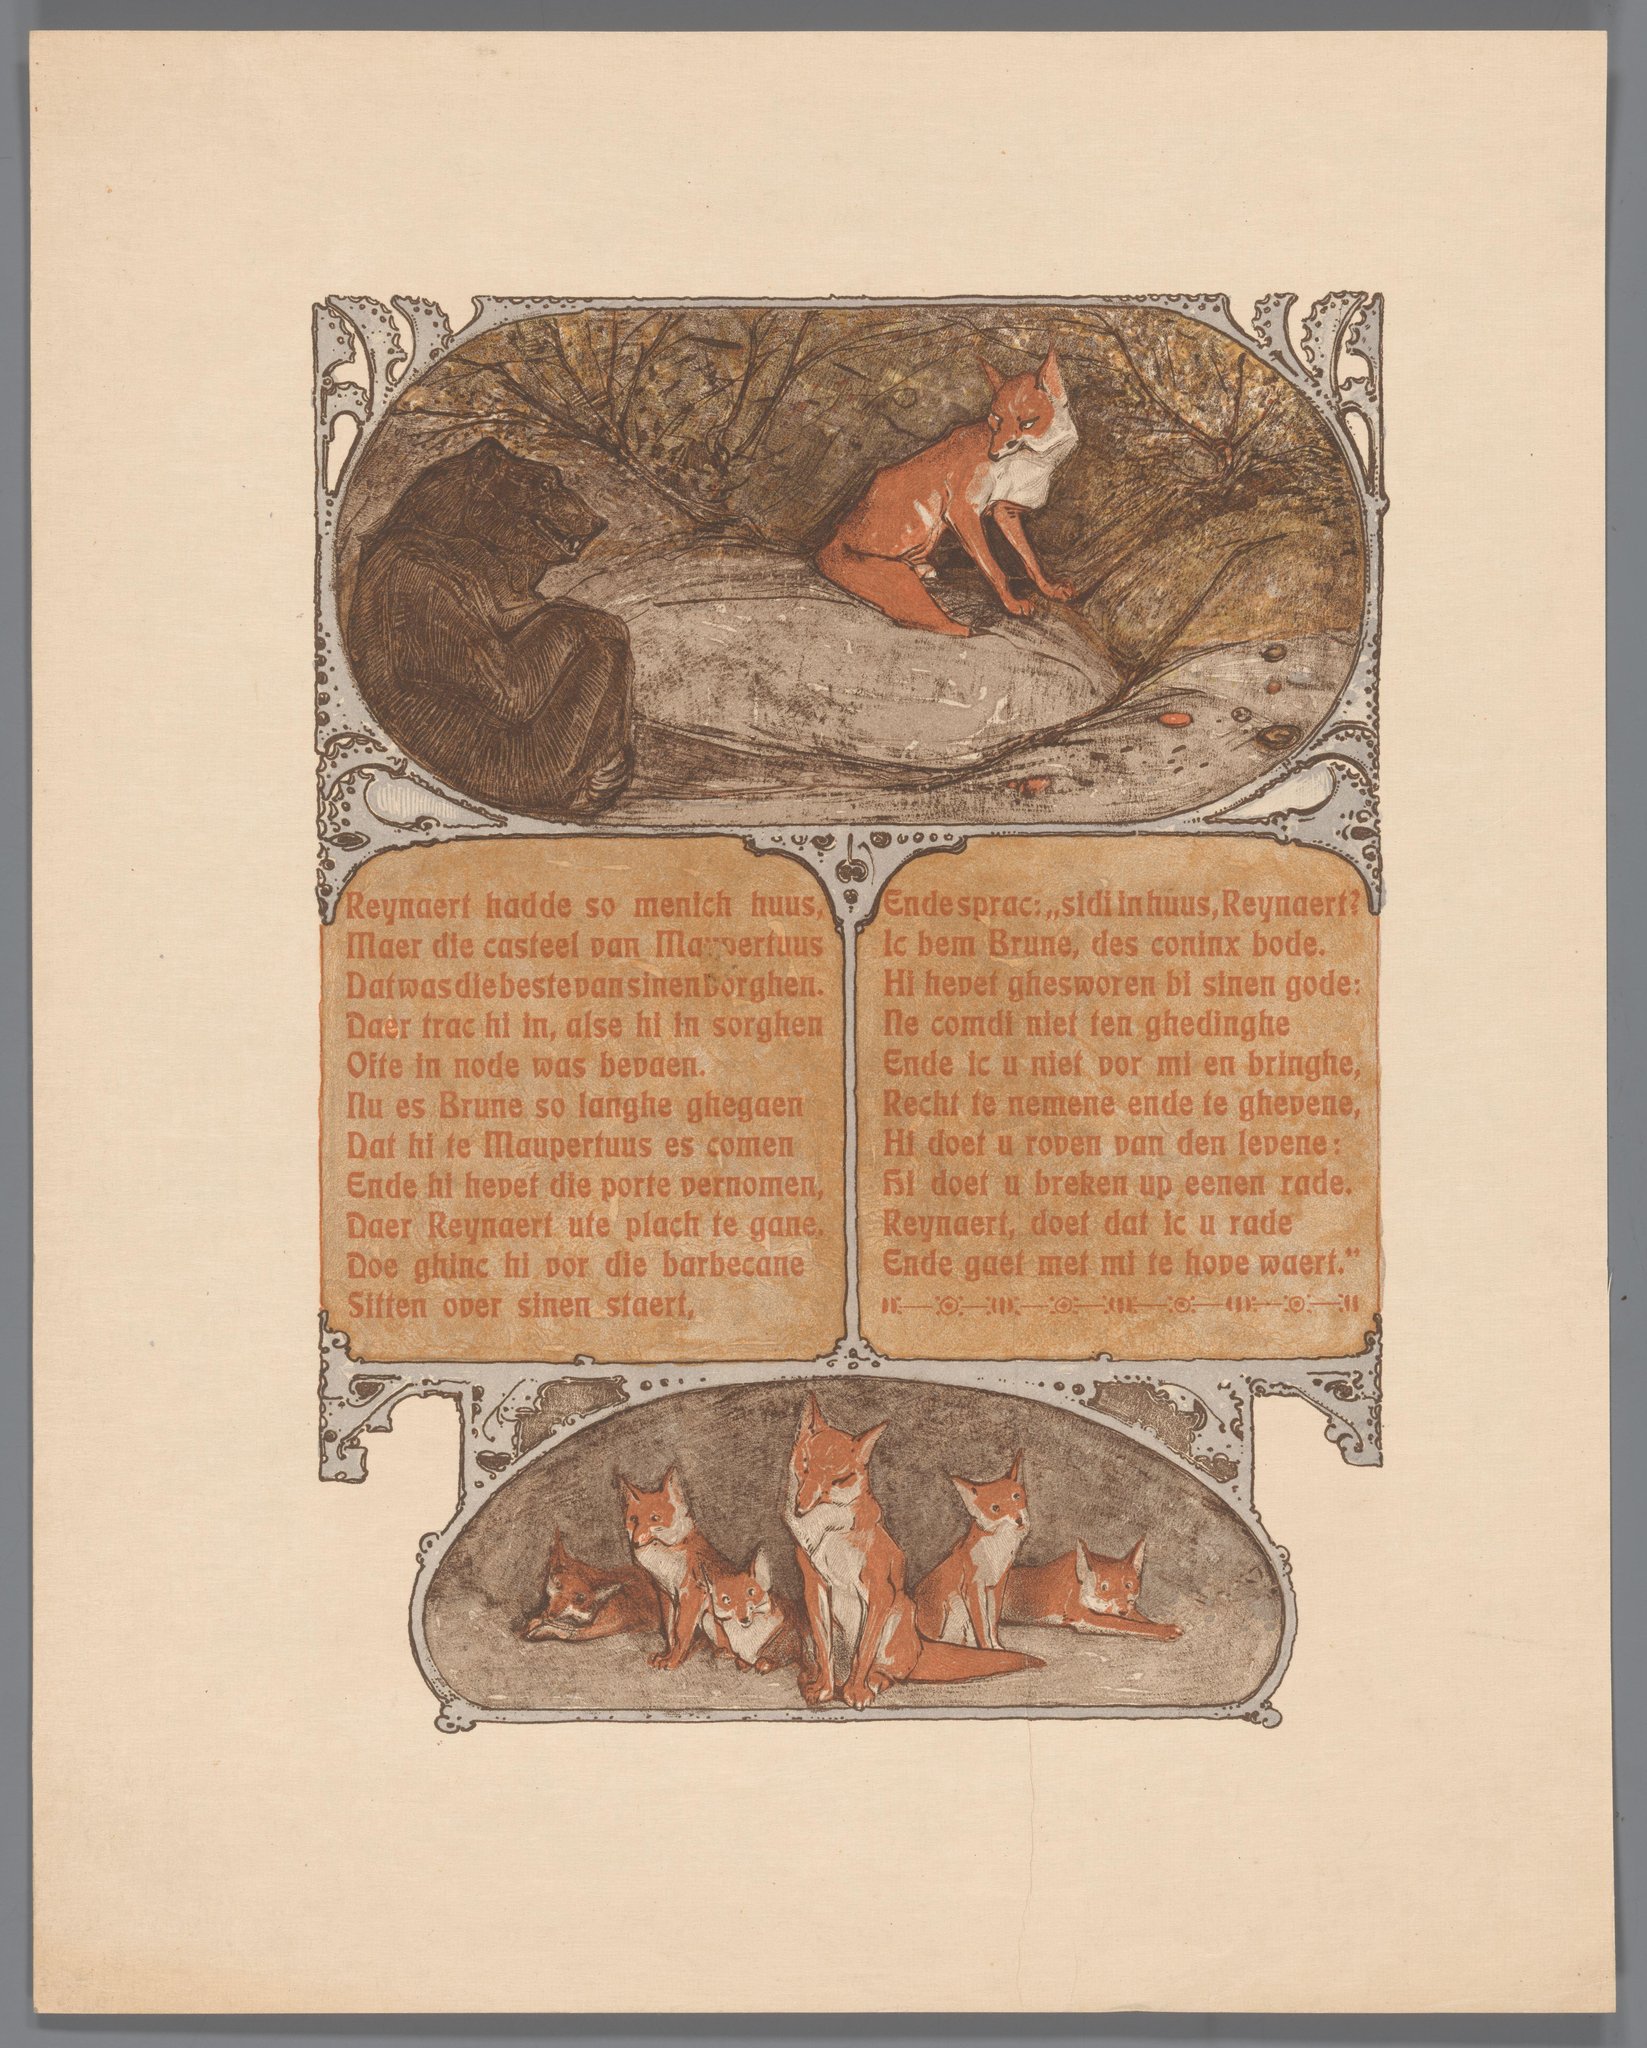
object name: book illustration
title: Beer (Bruun) en vos (Reinaert)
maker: bernard willem wierink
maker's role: draughtsman, print maker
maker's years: 1856-1939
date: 1910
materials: paper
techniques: lithograph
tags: fable of reynard the fox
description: Prent gebruikt in: Streuvels, Stijn (Frank Lateur). Reinaert de Vos naar verschillende uitgaven van het middeleeuwsche epos. Amsterdam: L.J. Veen, 1910.